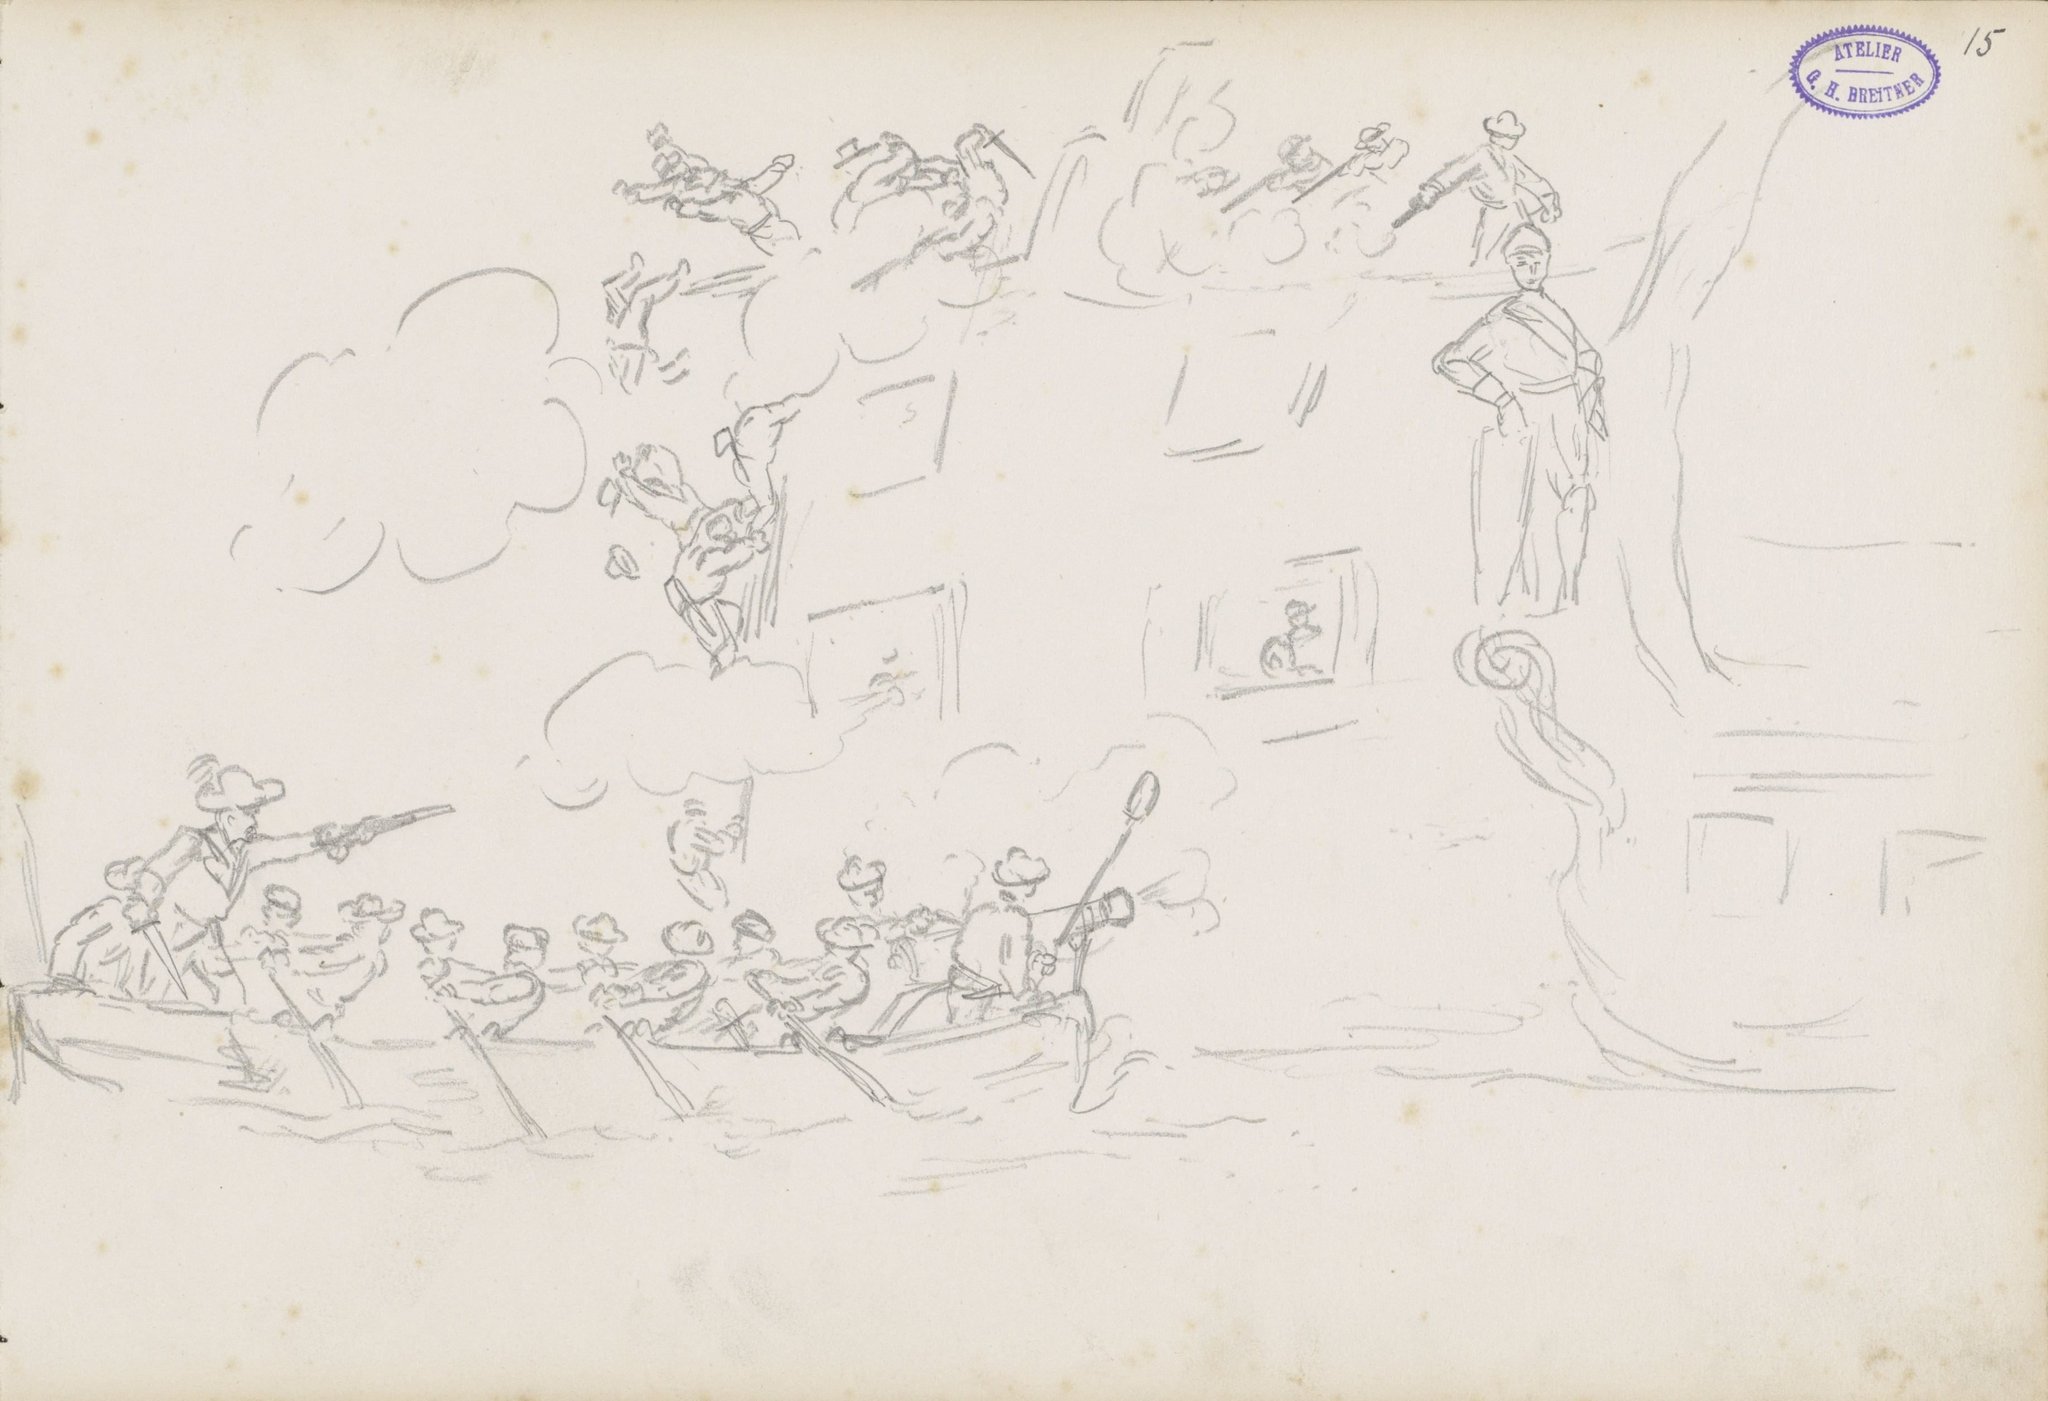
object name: drawing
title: Zeeslag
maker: george hendrik breitner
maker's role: draughtsman, painter, print maker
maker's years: 1857-1923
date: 1872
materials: paper, pencil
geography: rotterdam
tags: battle (+ naval force)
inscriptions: workshop stamp: Lugt 291d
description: Deze tekening heeft oorspronkelijk als blad 15 deel uitgemaakt van een schetsboek. Zie voor dit schetsboek het gerelateerd object.